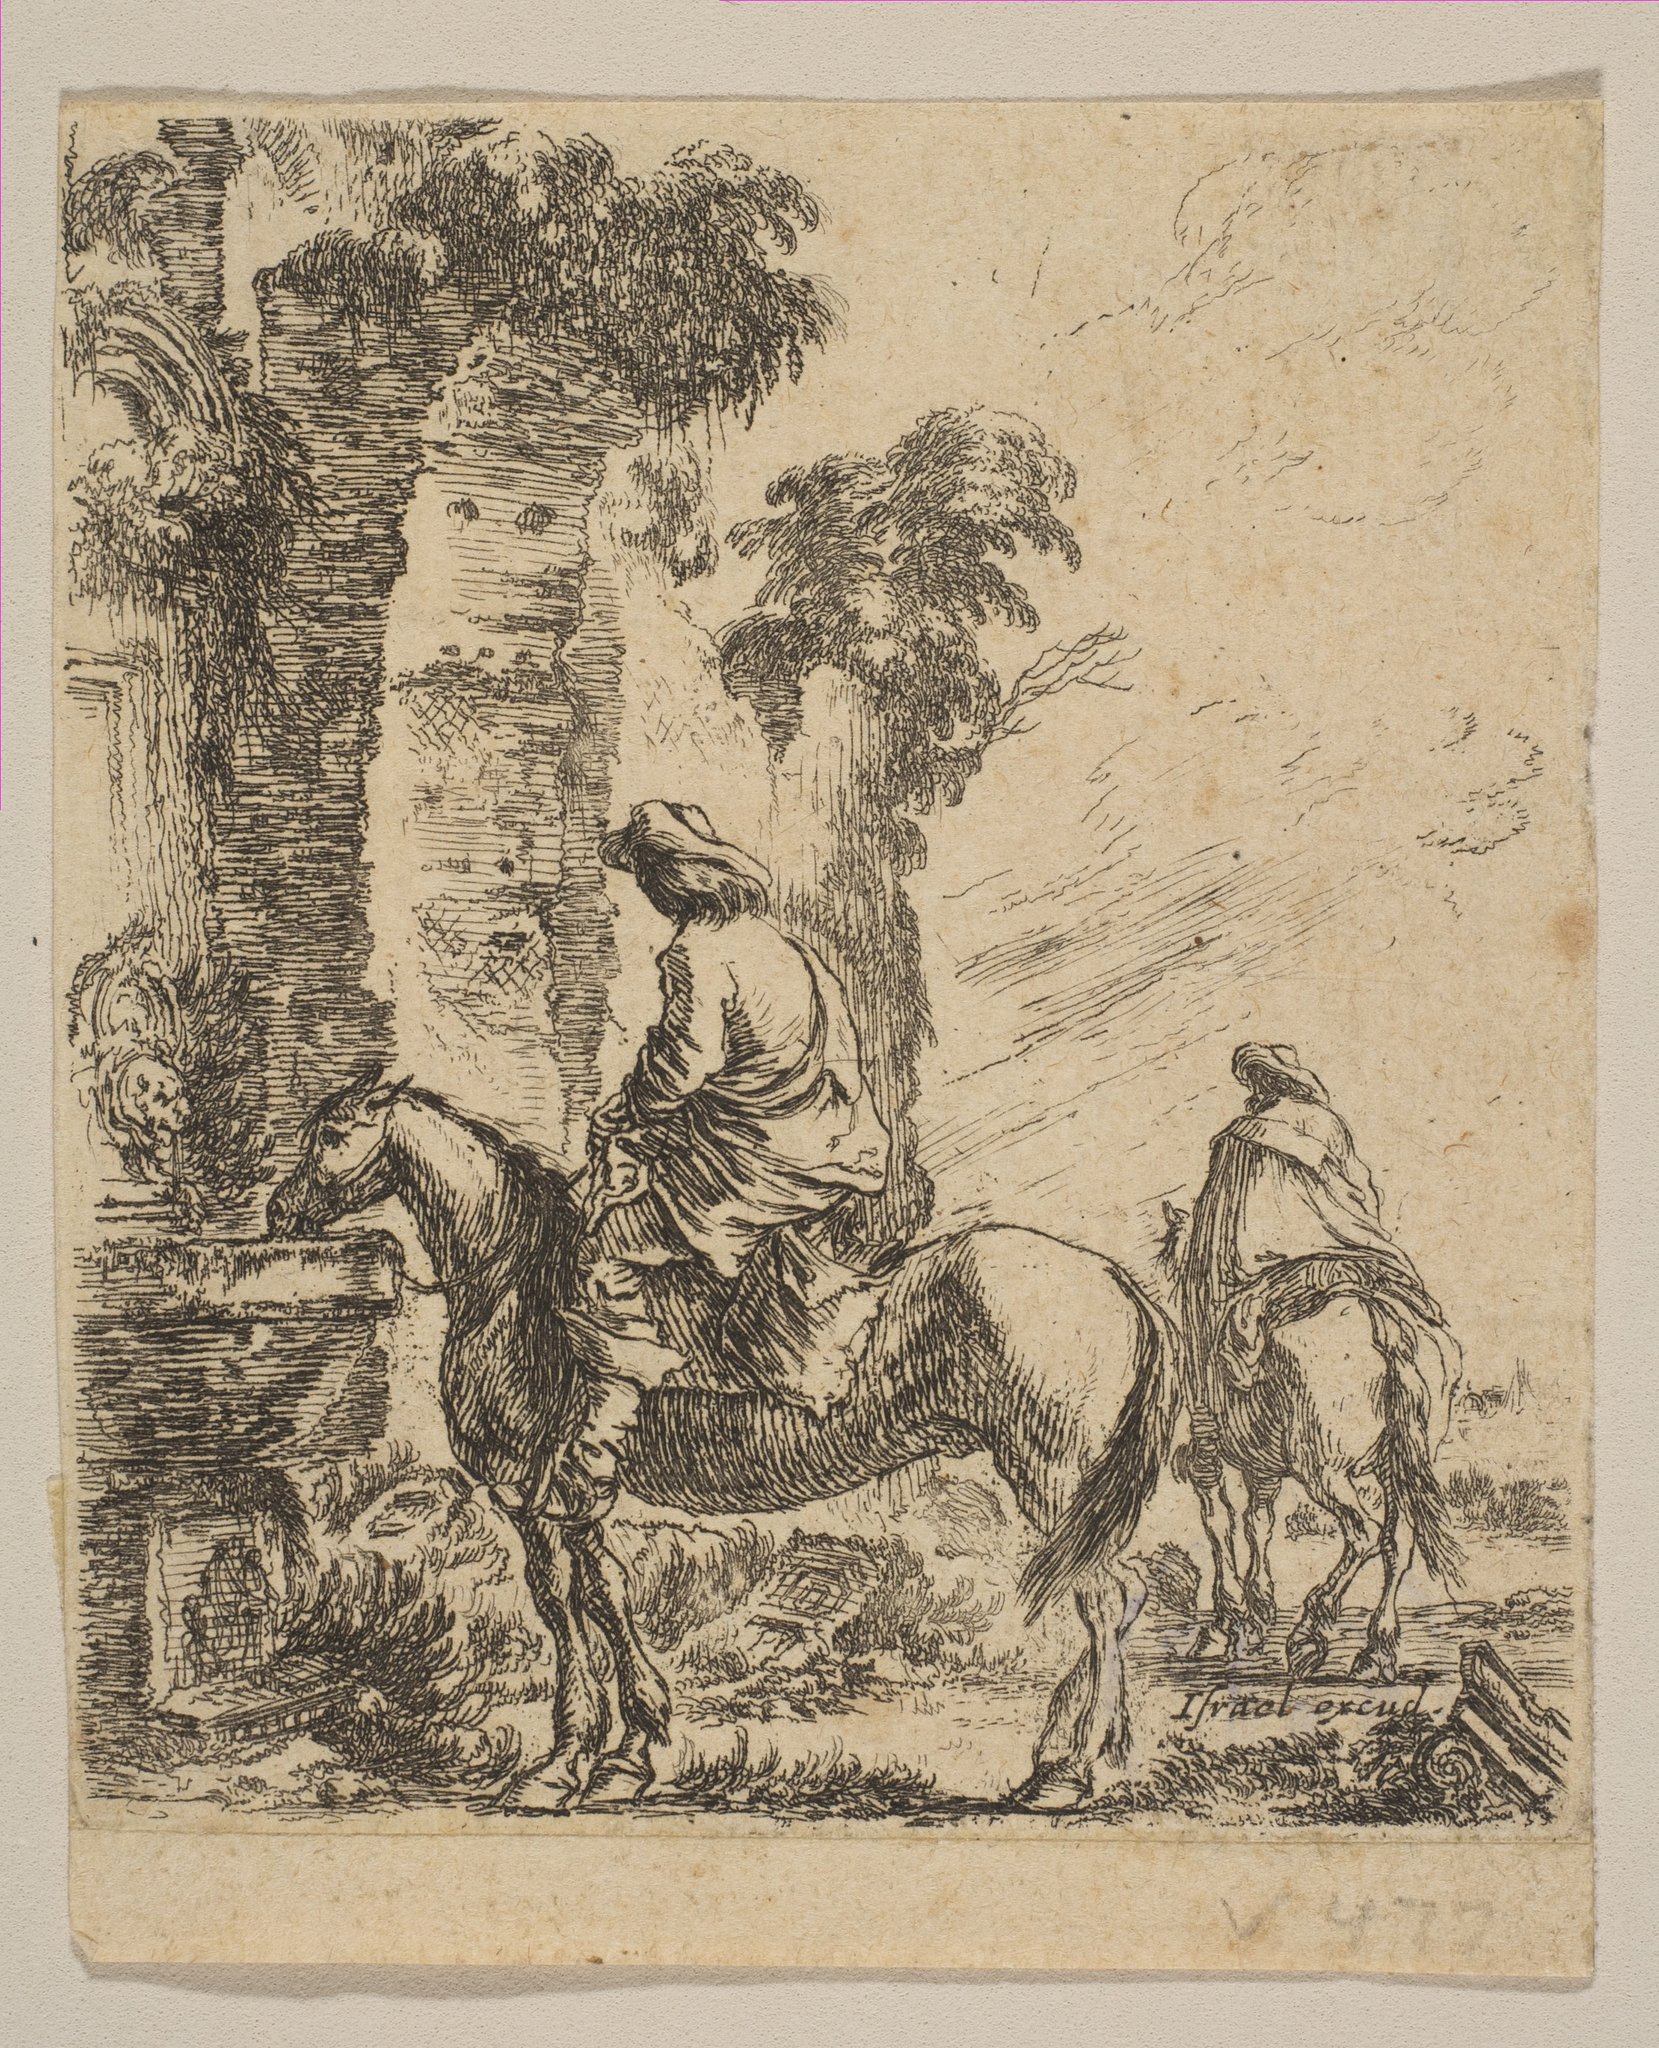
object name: print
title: Plate 19: Landscape with a Cavalier Watering His Horse at a Fountain, from "Various figures and doodles" (Diverses figures et griffonnemens)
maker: stefano della bella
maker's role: artist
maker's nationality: italian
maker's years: 1610-1664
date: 1646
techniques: etching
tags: fountains,men,horses,trees